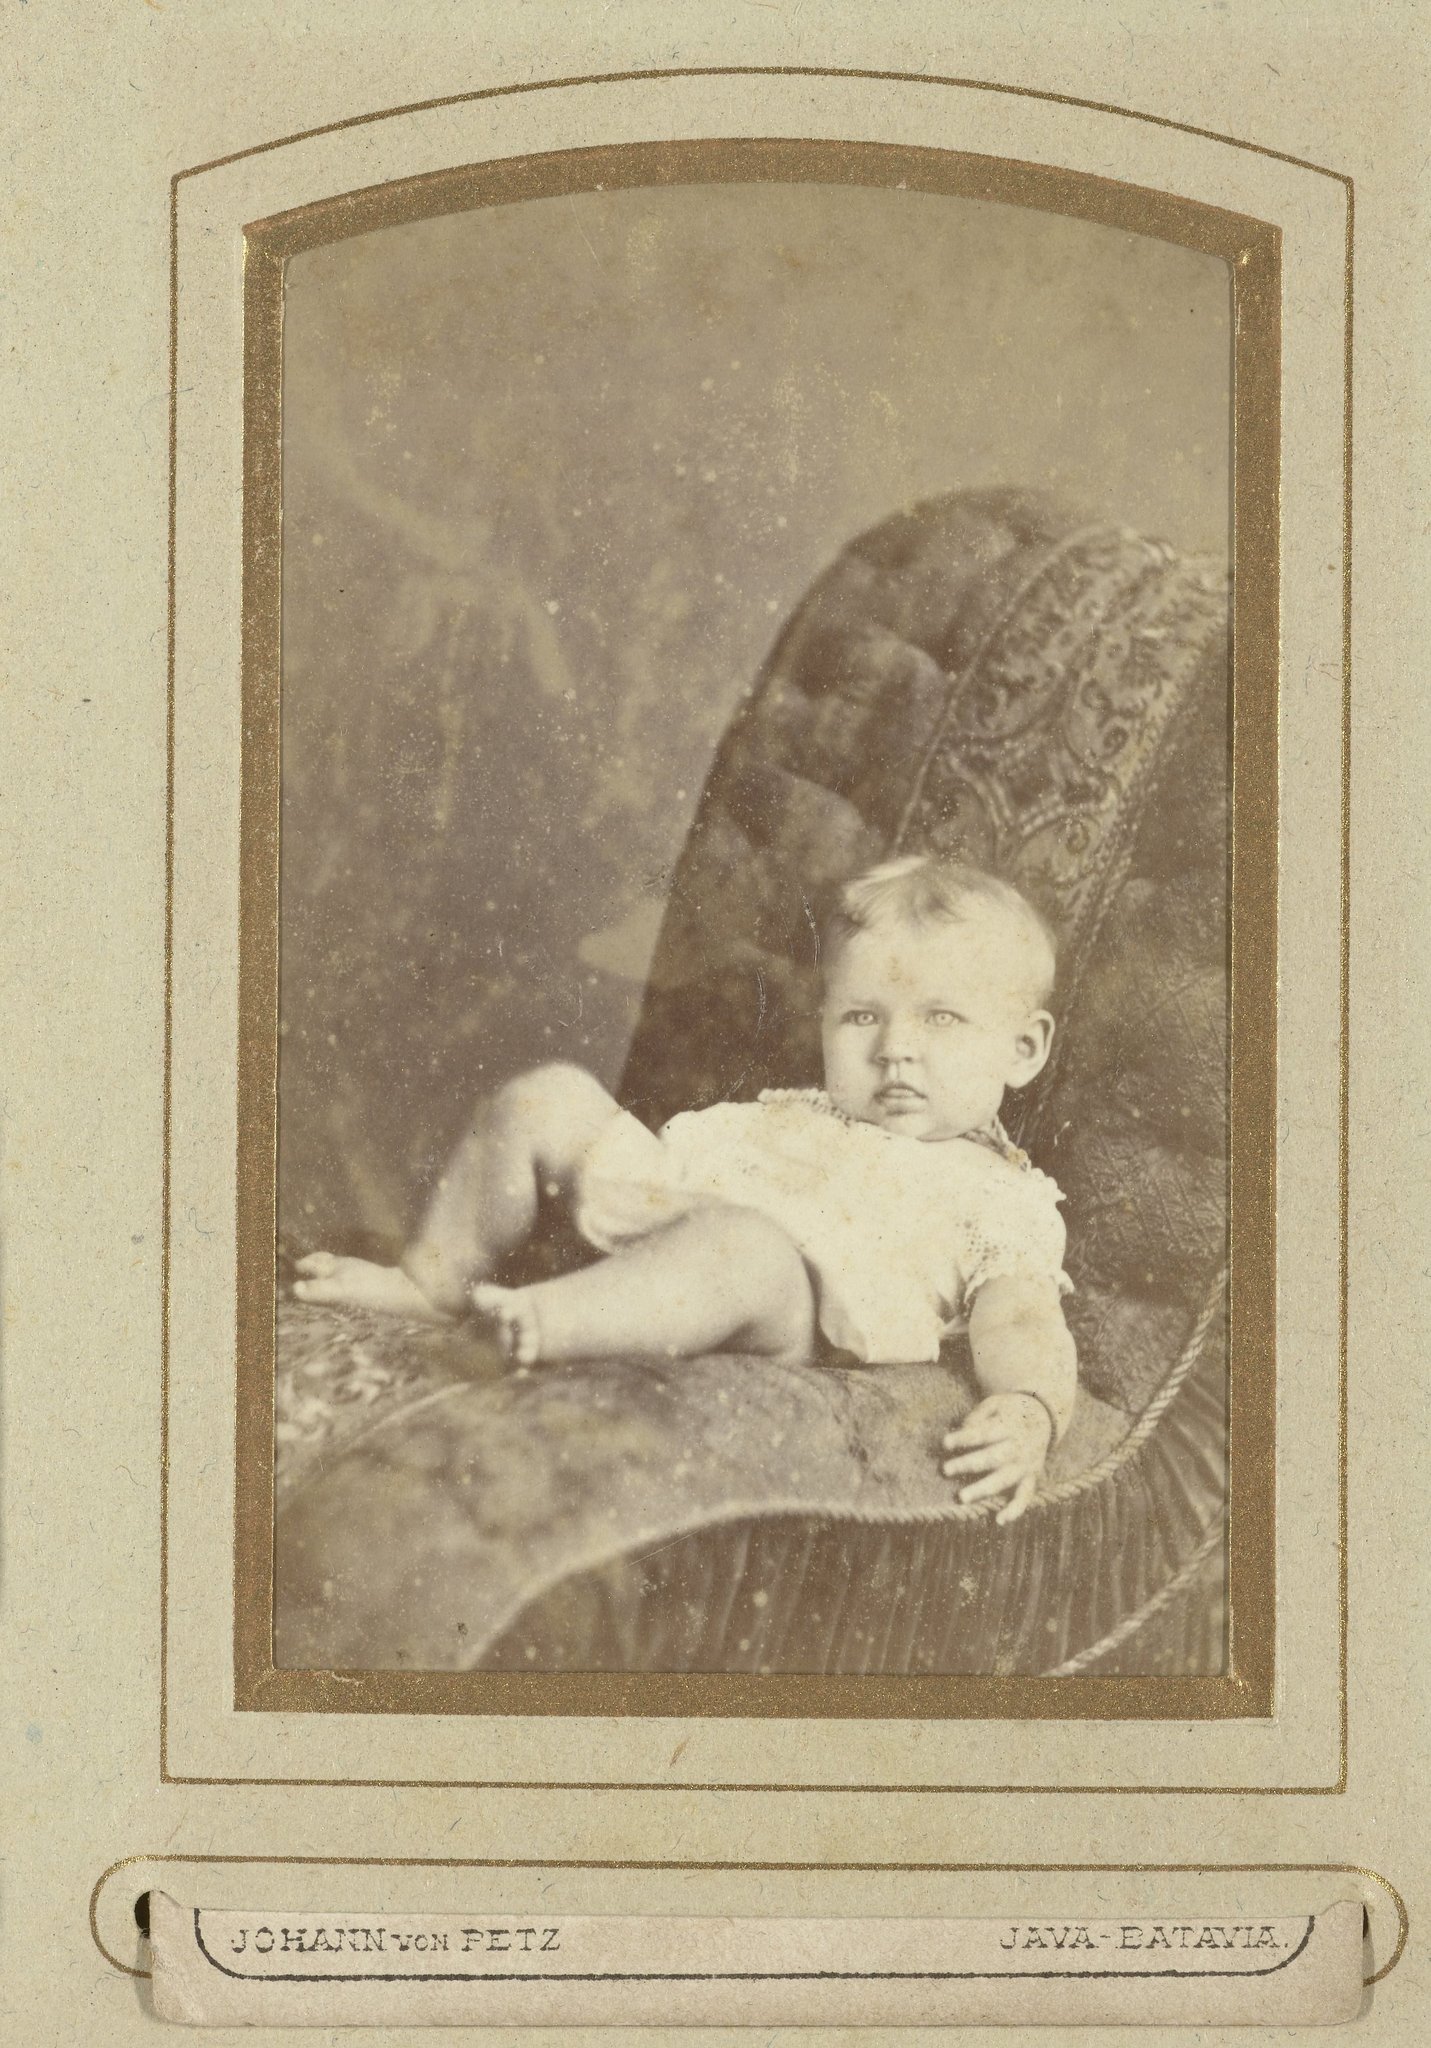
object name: carte de visite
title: Portret van een baby op een stoel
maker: johann von petz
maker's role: fotograaf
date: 1890-1910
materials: paper, photographic support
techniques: photography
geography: java